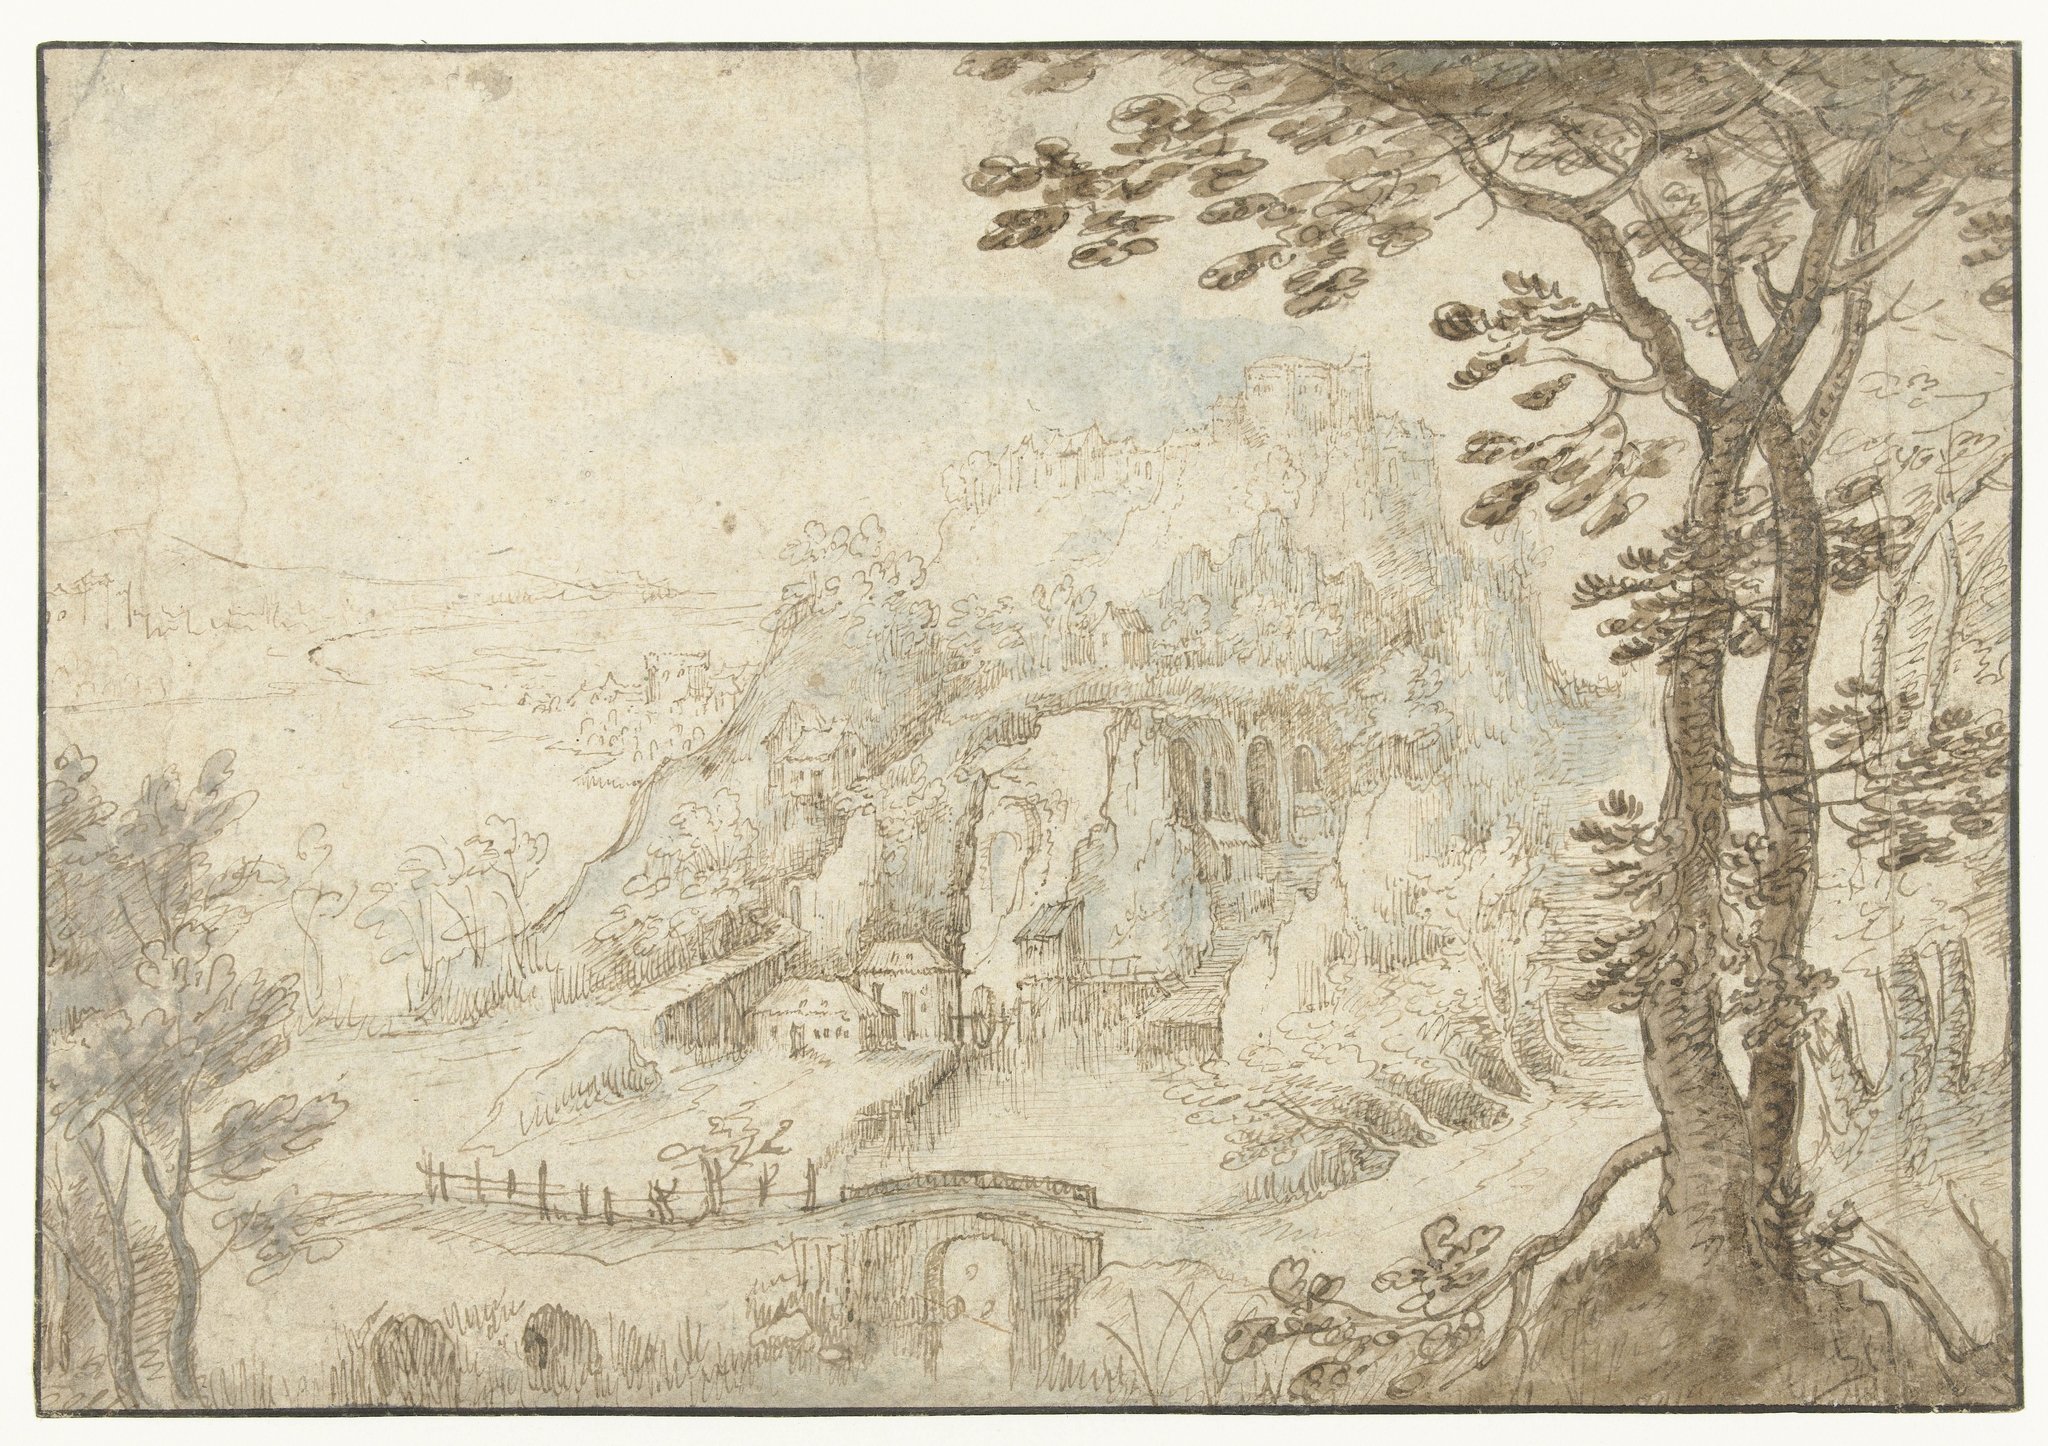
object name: drawing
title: Berglandschap met een rivier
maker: gilles van coninxloo (ii)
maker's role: draughtsman, painter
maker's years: 1544-1607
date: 1554-1607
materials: ink, paper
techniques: brush, pen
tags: river, (high) hill